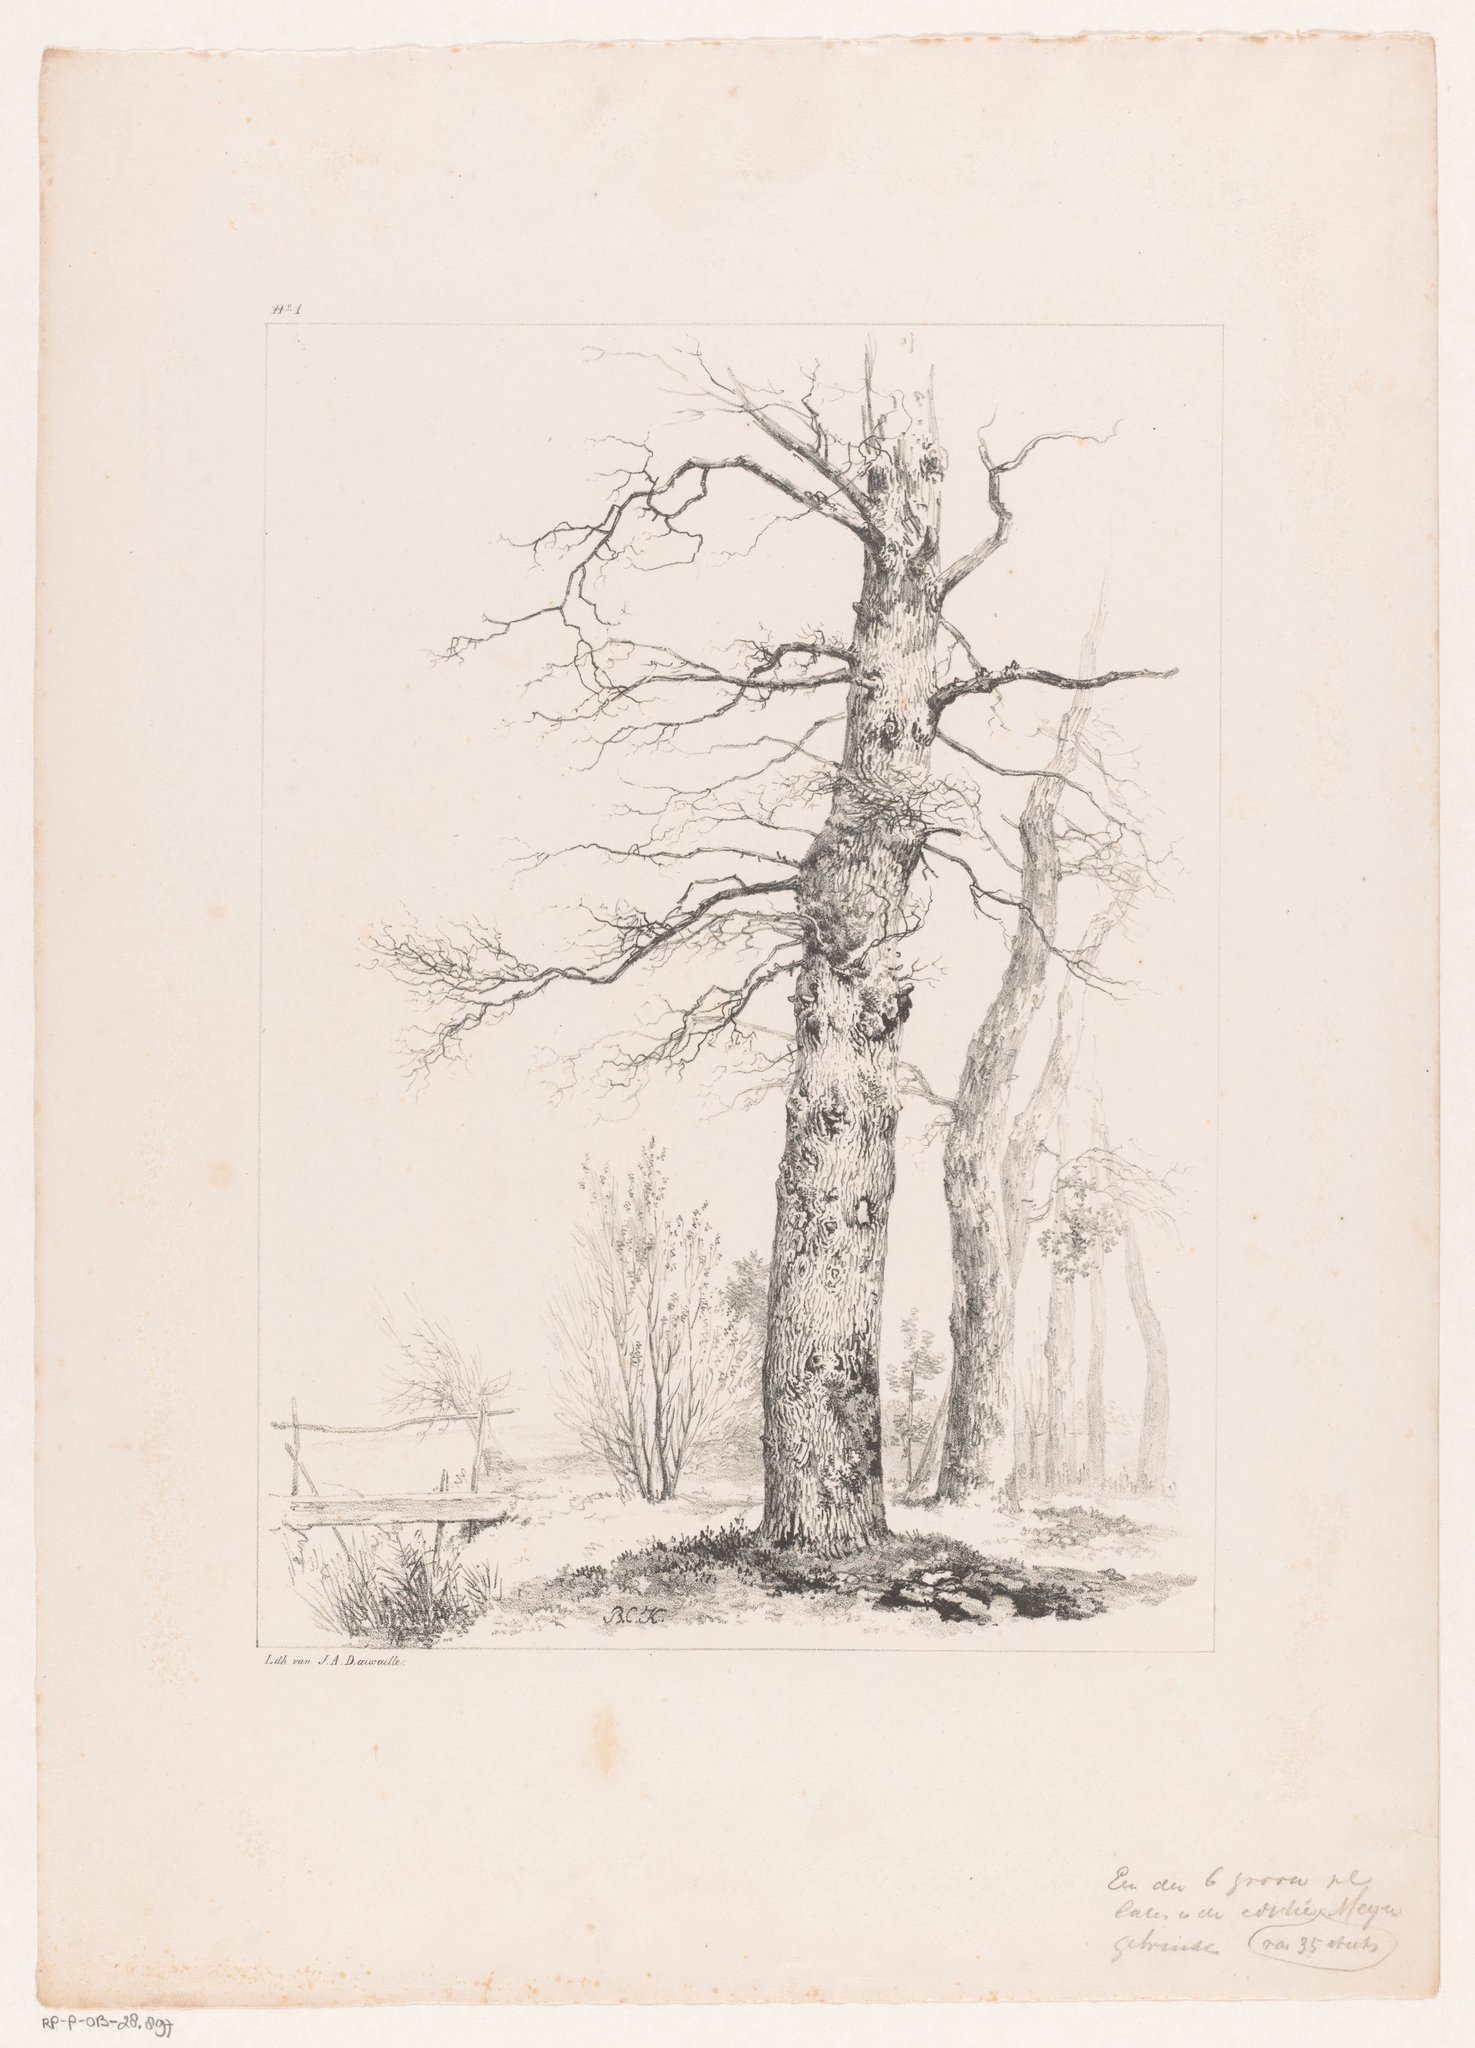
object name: print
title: Landschap studiën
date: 1829-1830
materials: paper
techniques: lithograph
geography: amsterdam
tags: shrubs, groups of trees, bridge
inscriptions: collector's mark: Lugt 2228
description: In 1829 en 1830 gaf Koekkoek, samen met Daiwaille, zes cahiers uit met ieder zes prenten getiteld Landschapstudiën. Deze werden gebruikt in het tekenonderwijs. Vijftien jaar later werd deze reeks, in een andere samenstelling nogmaals uitgegeven door Meyer en Comp in Amsterdam. Zie: De Bruyn Kops, 1963 en Nollert, 1997.